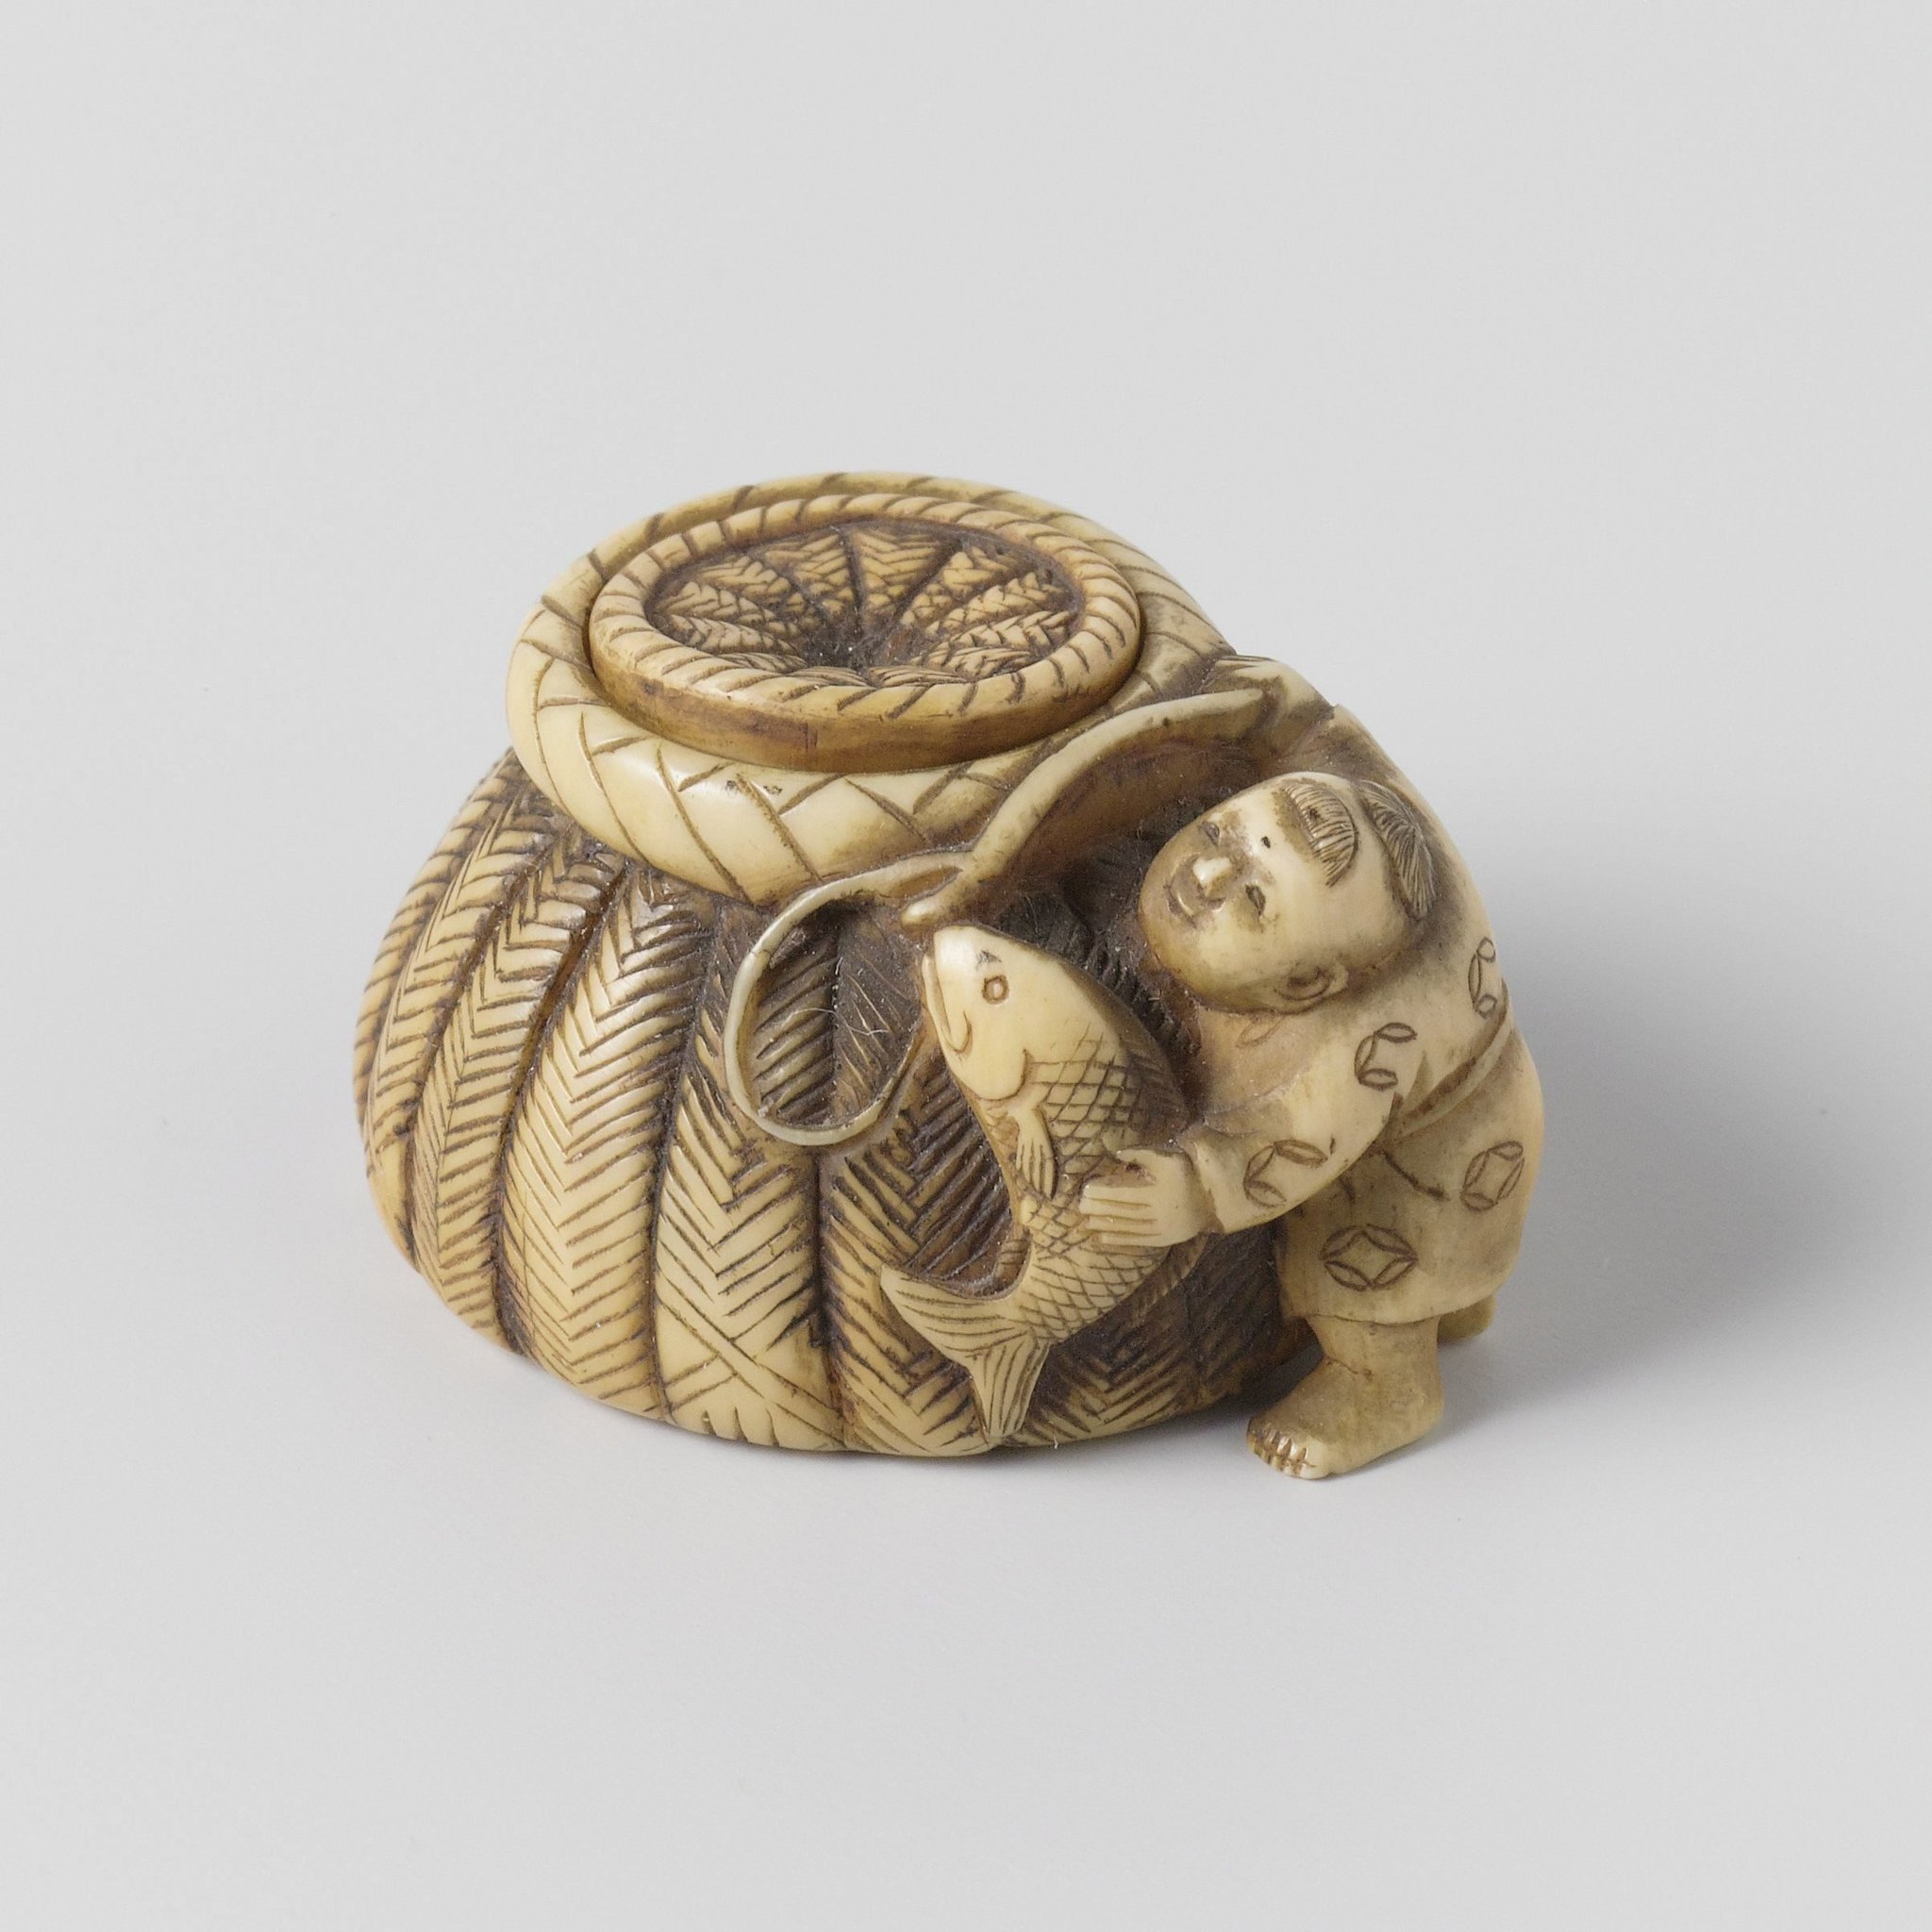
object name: netsuke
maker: Anonymous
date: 1700-1900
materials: ivory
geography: japan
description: Uitbeelding van een grote rieten mand met afneembare deksel. Een klein mannetje ter hoogte van de mand houdt een grote vis in zijn linker hand.